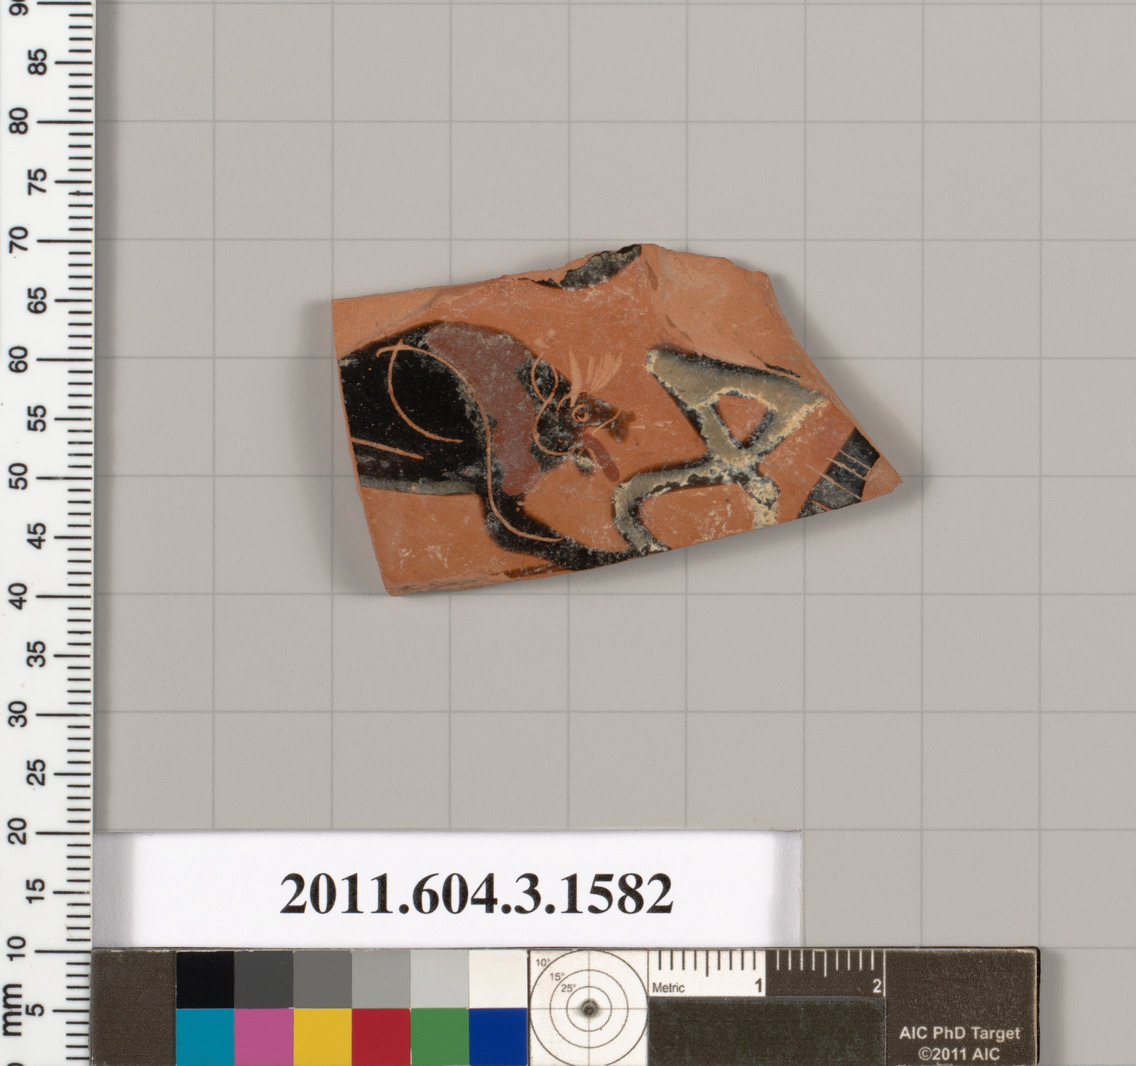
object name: kylix fragment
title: Terracotta fragment of a kylix: Band cup (drinking cup)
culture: greek, attic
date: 550-526 BCE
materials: terracotta